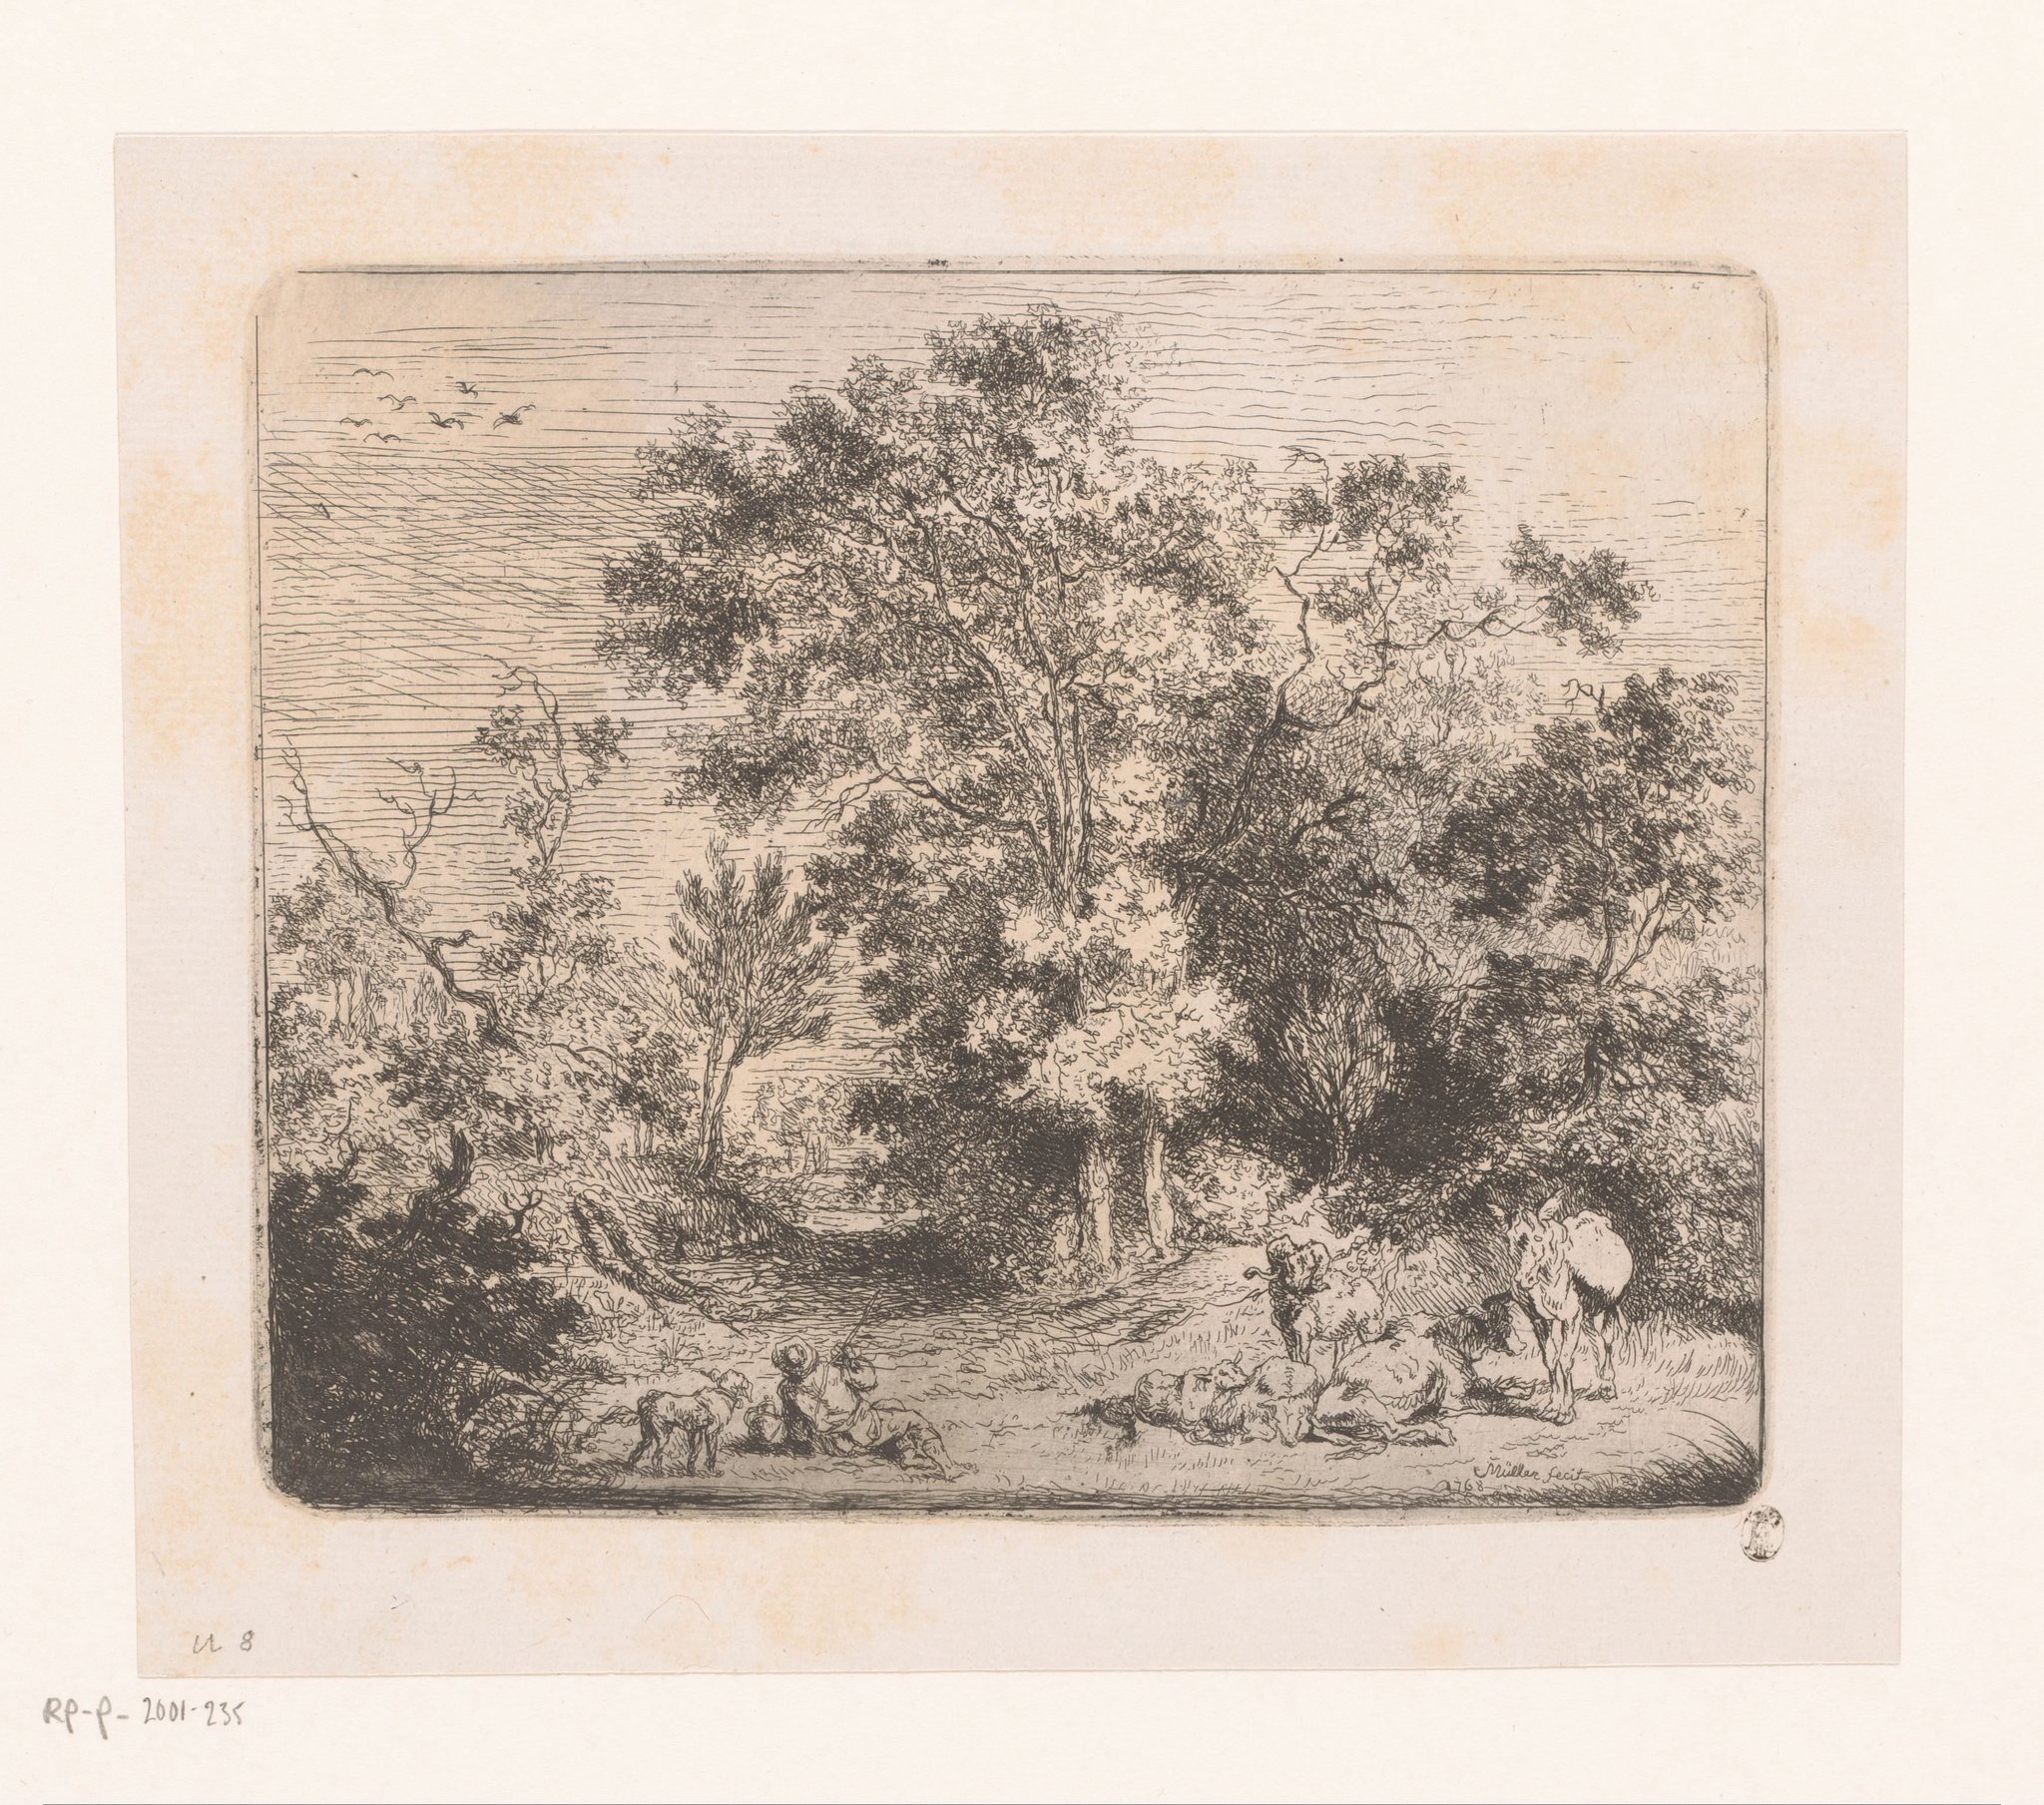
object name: print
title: Landschap met herder en kudde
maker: friedrich müller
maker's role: painter, print maker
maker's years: 1749-1825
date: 1768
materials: paper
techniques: etching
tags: landscapes, herding, herdsman, herdswoman, shepherd, shepherdess, cowherd, etc.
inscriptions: collector's mark: Lugt 2228, collector's mark: Lugt 971